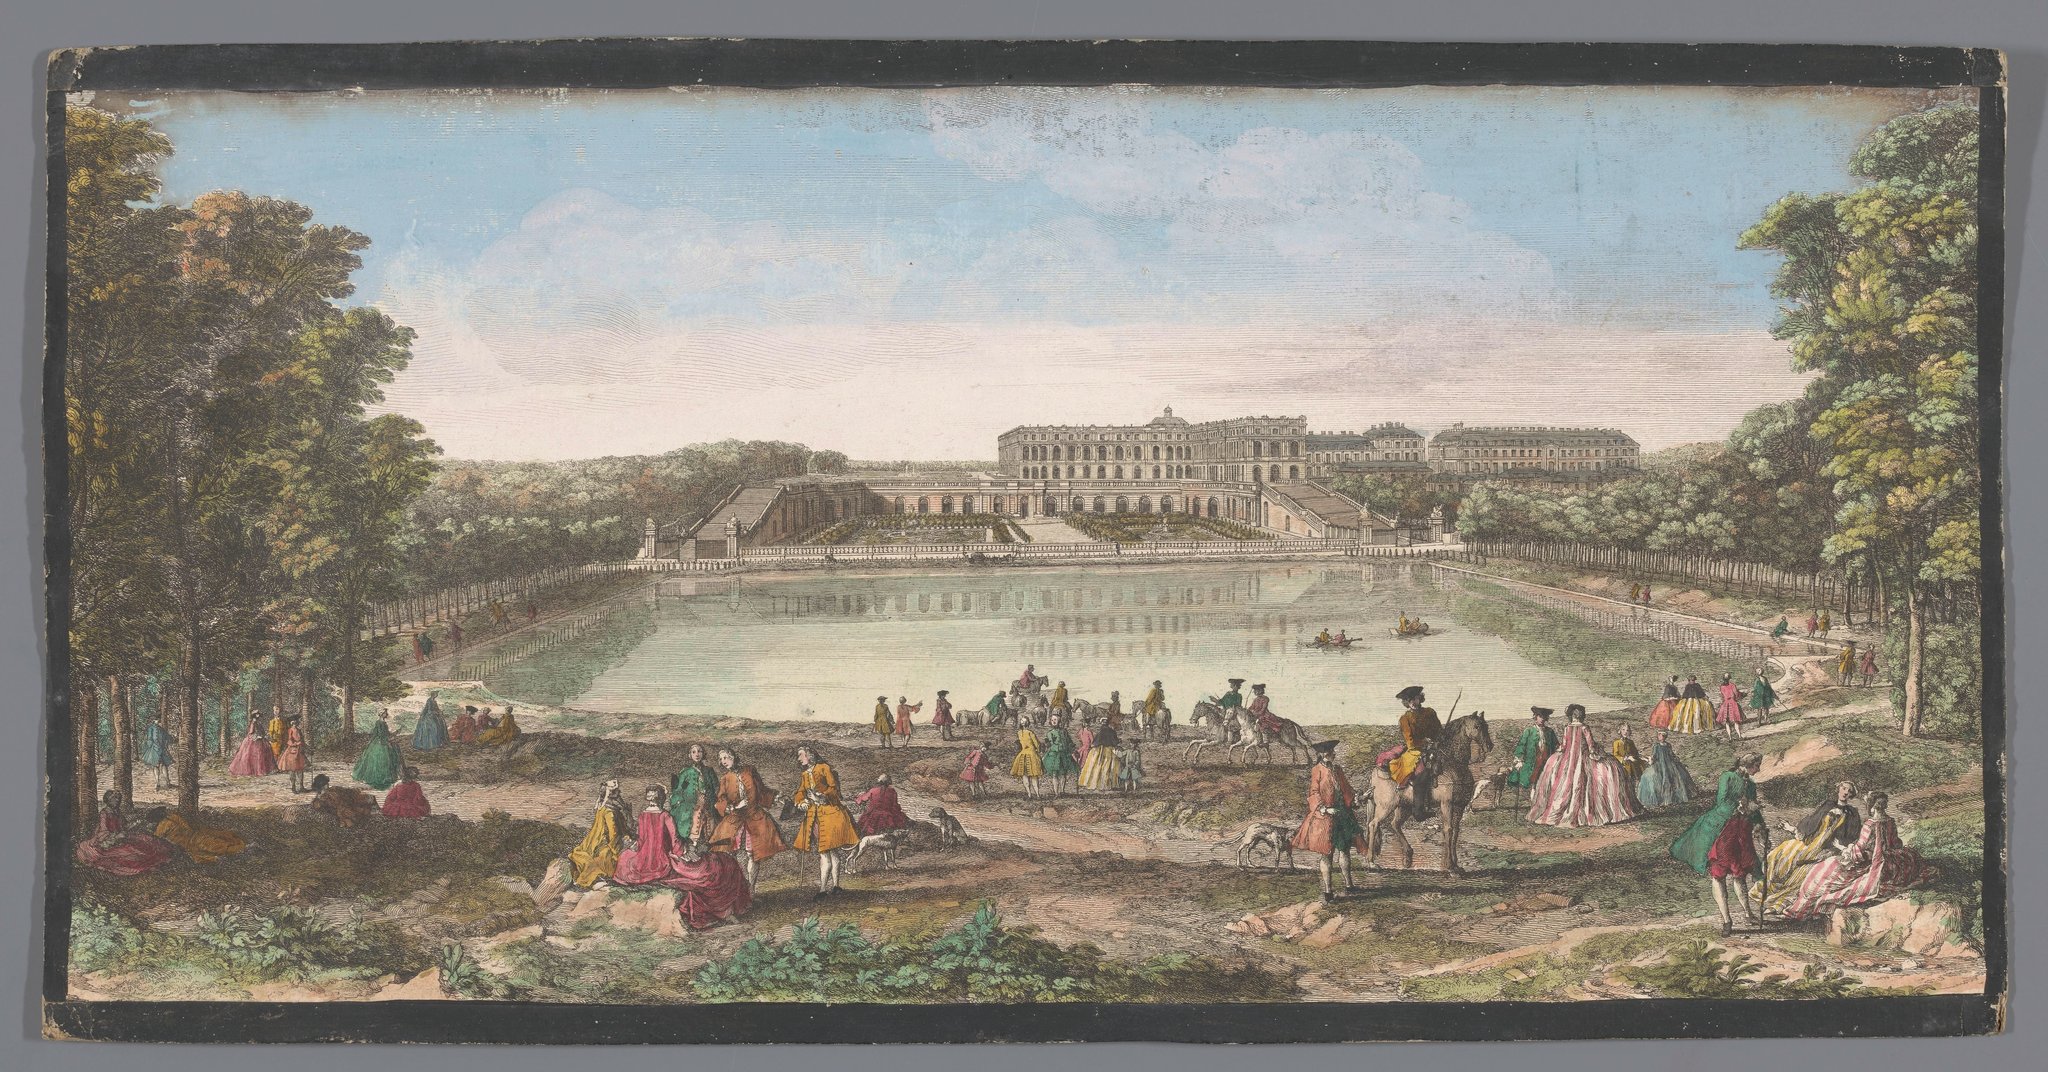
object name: print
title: Gezicht op de Orangerie van het Paleis van Versailles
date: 1700-1799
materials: cardboard, paper, watercolor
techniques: brush, etching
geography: paris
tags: palace, greenhouse, orangery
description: In de ondermarge een regel Franse tekst.